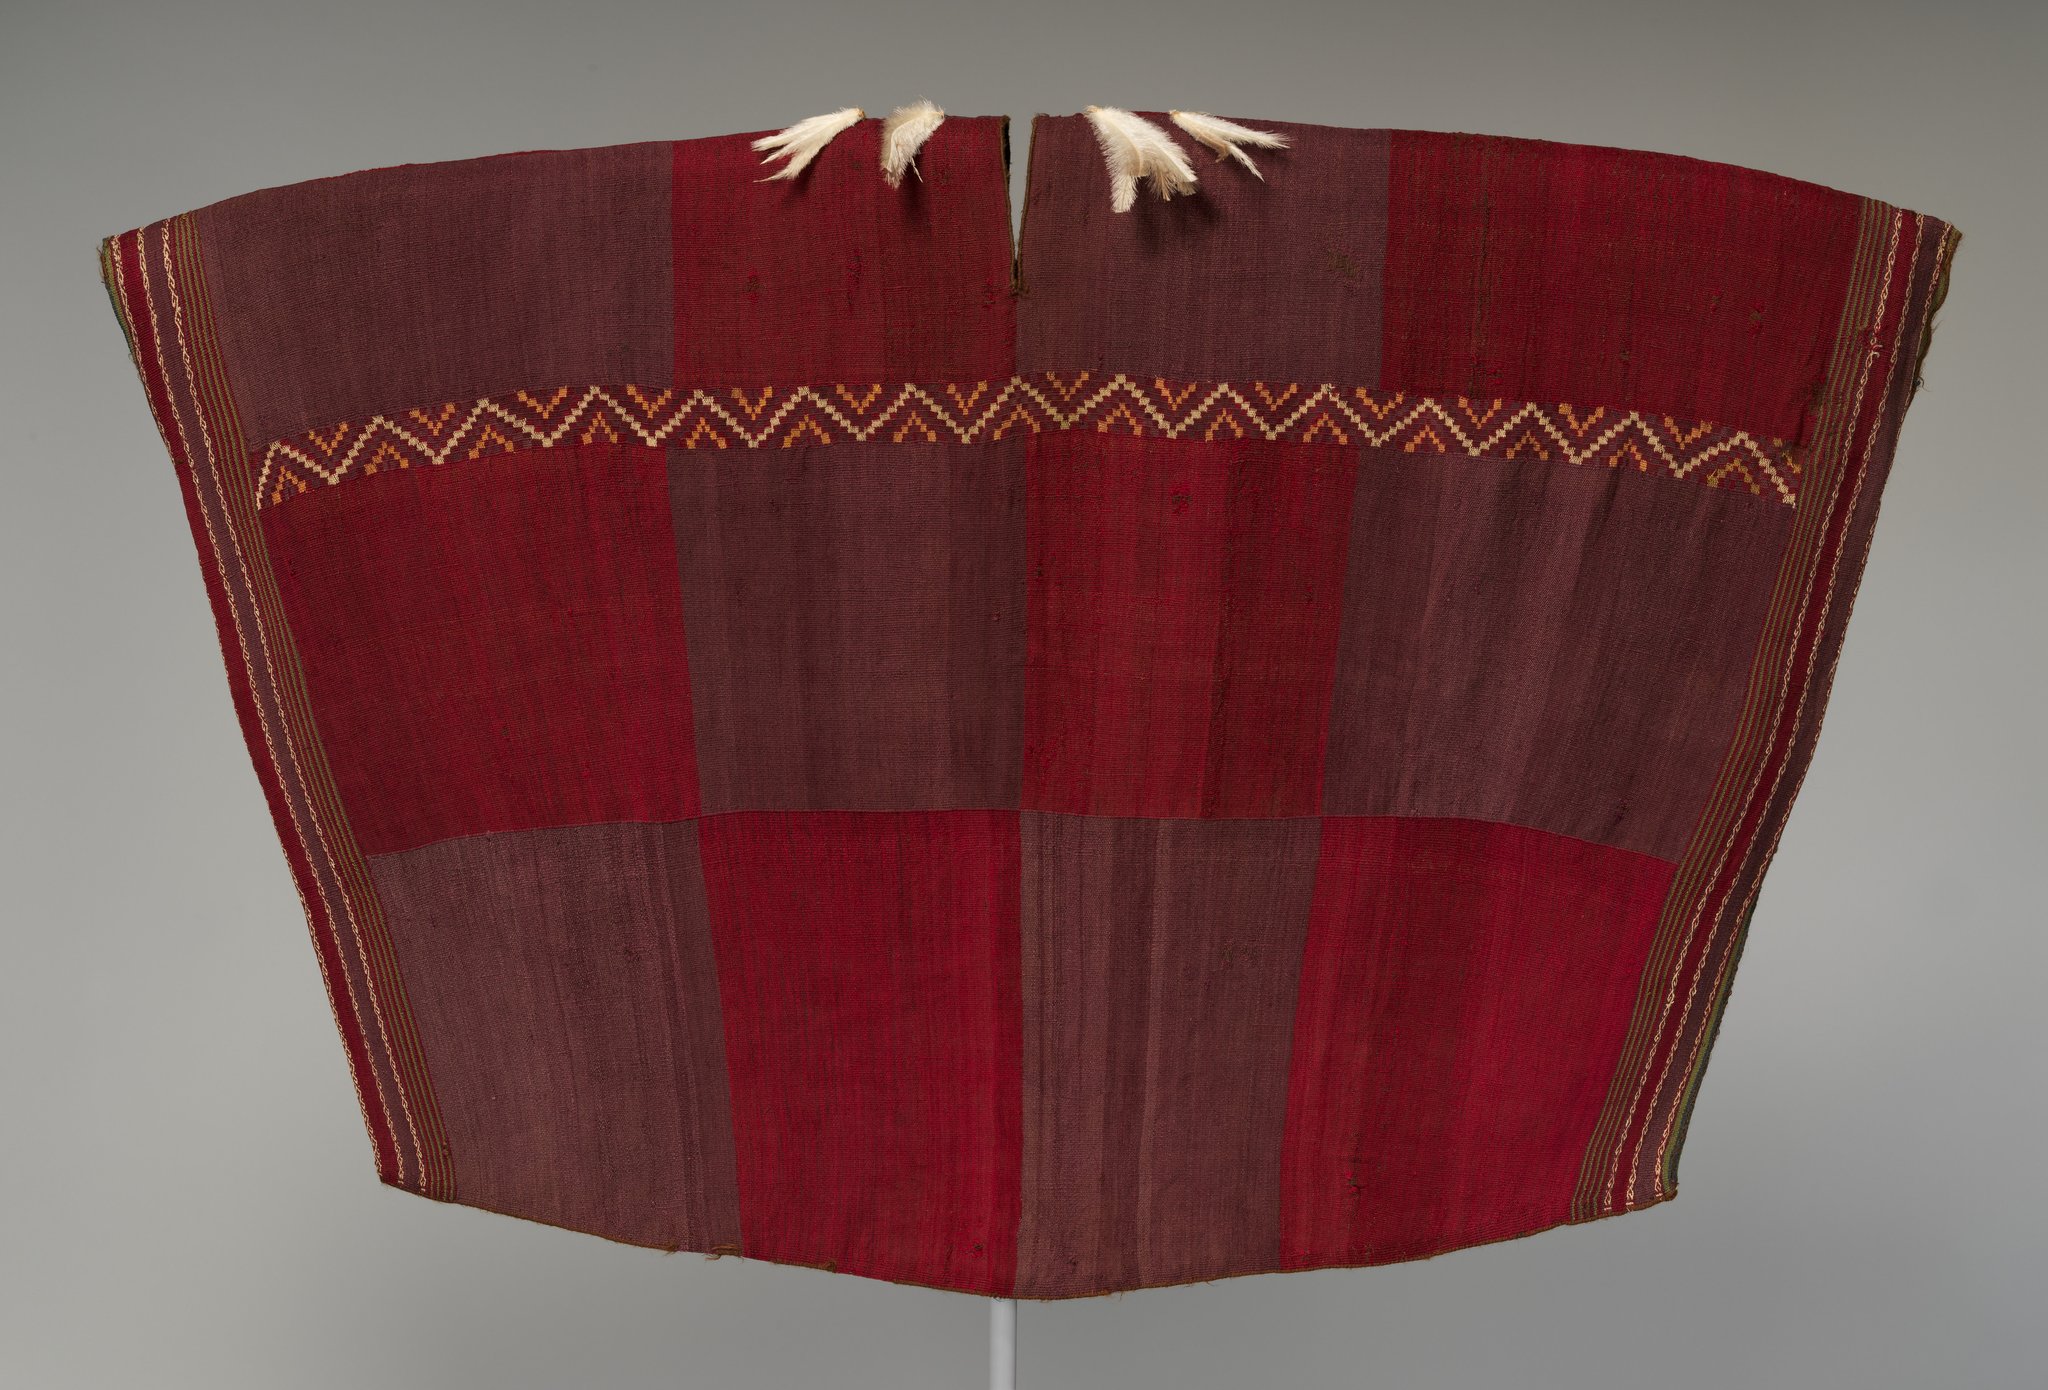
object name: tunic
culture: arica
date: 1401-1533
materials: animal fiber, feather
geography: chile